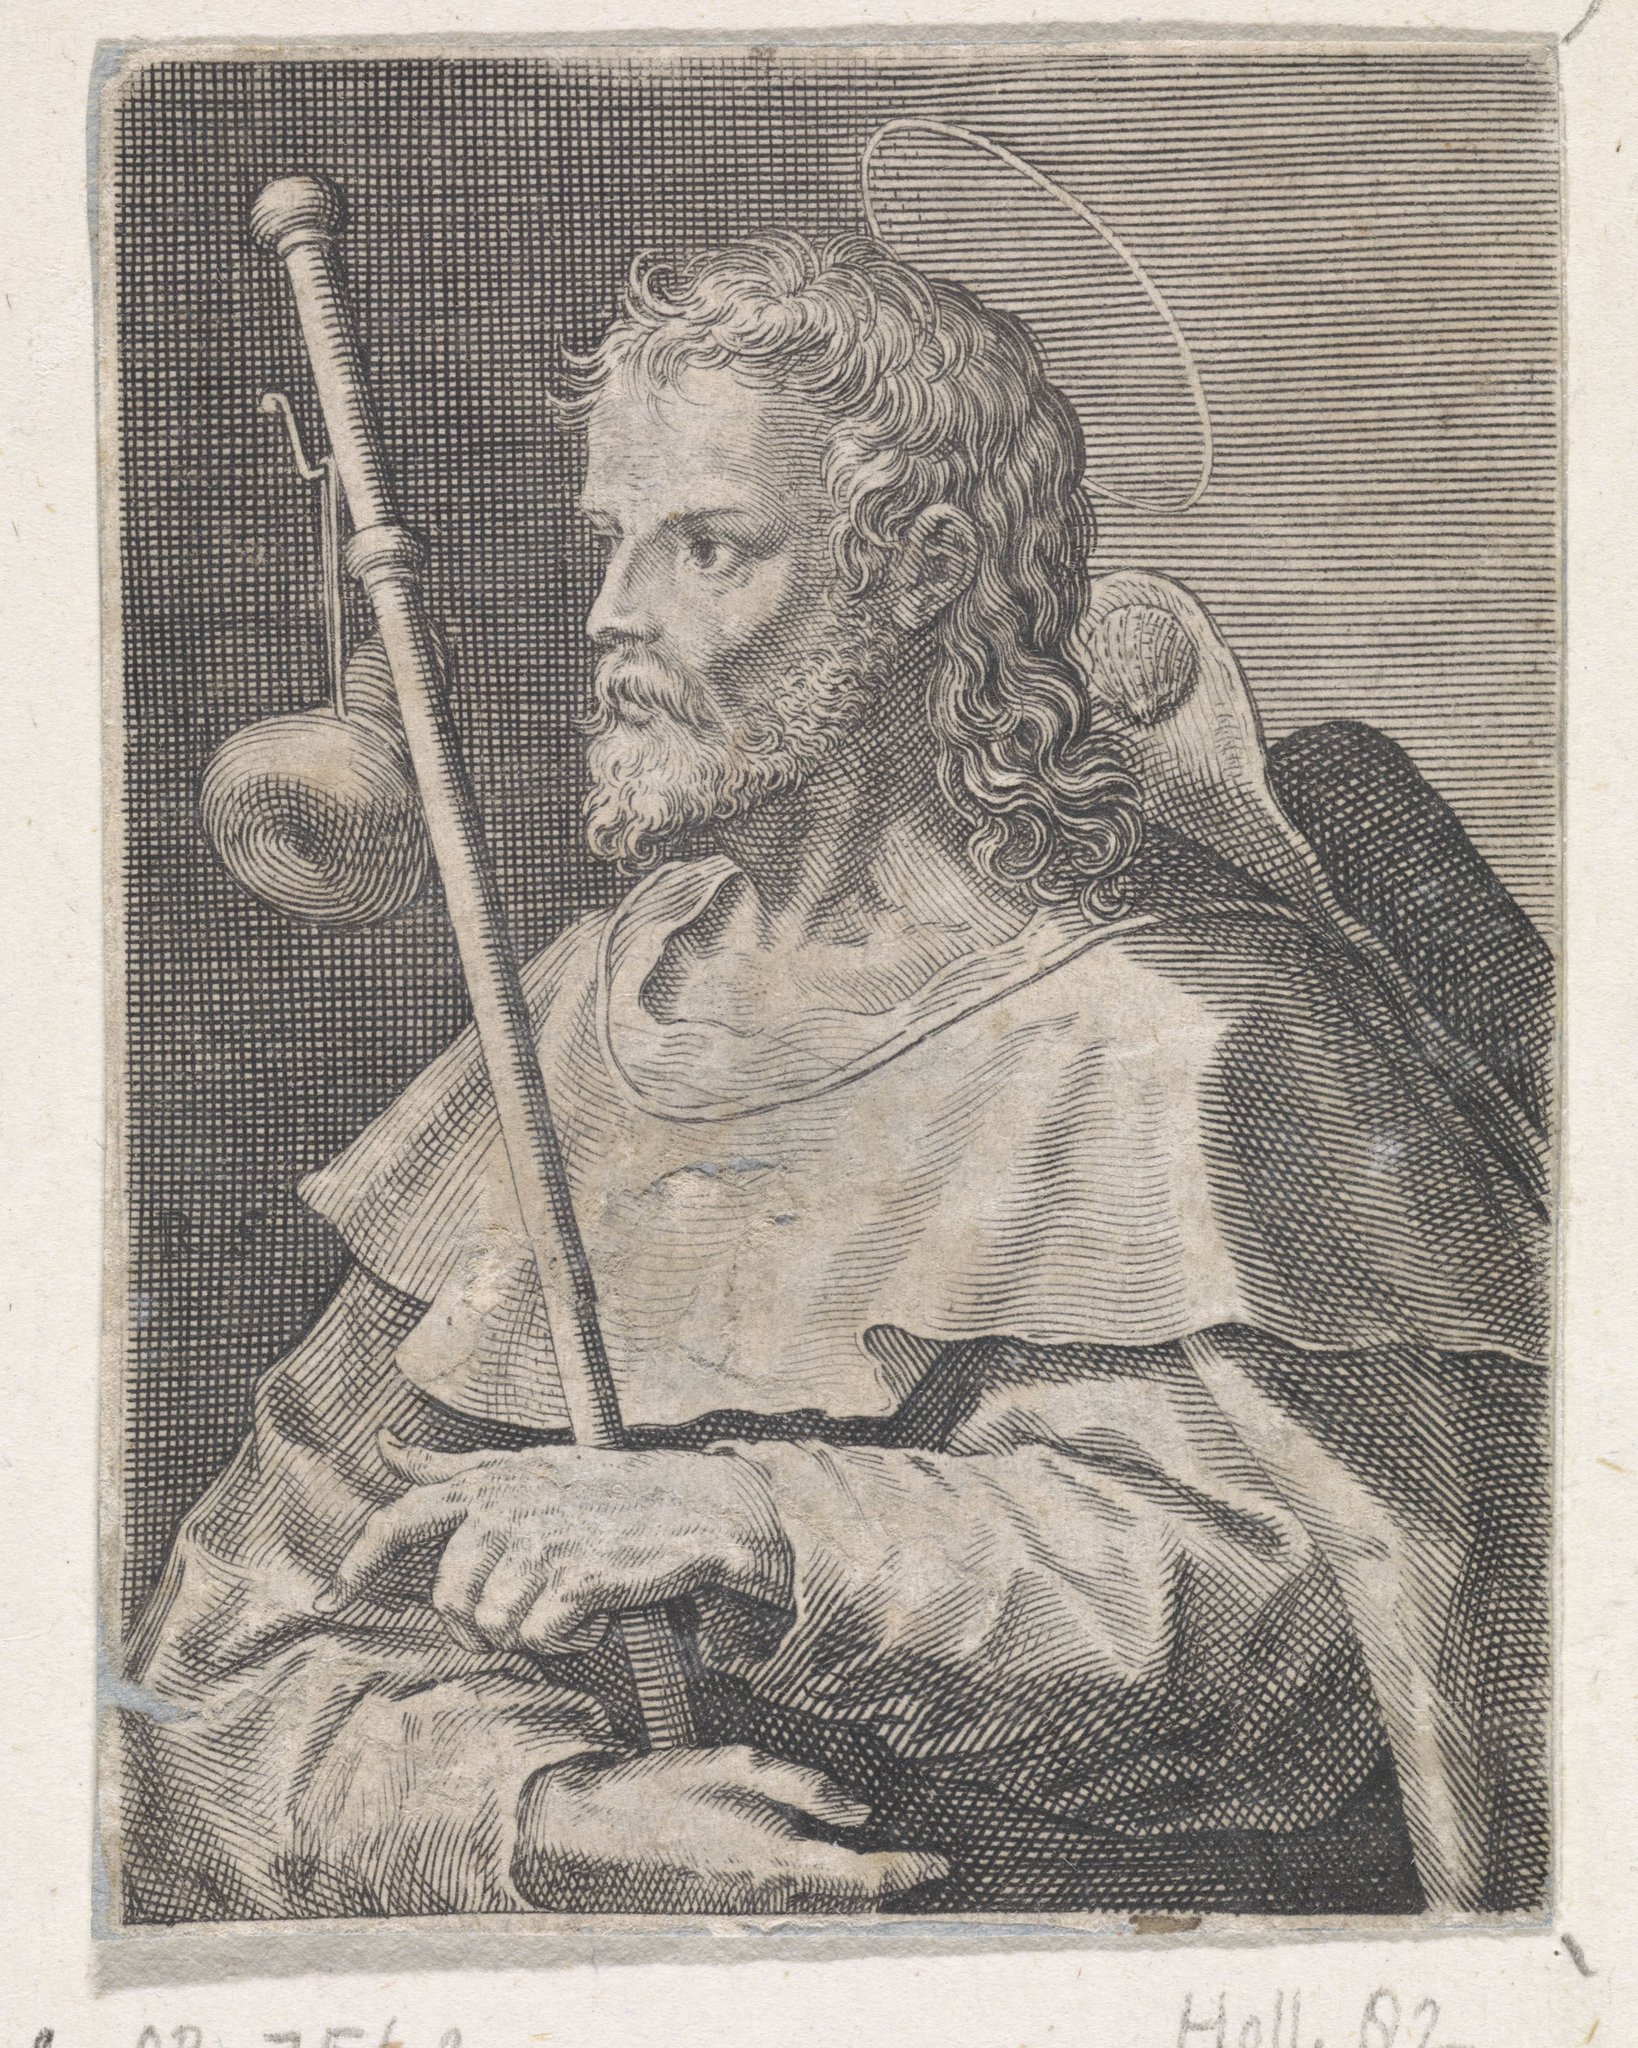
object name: print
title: Apostel Jakobus de Meerdere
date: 1570-1600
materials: paper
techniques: engraving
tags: the apostle james the great; possible attributes: book, pilgrim's cloak, hat, shell, staff, and wallet, scroll, sword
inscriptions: collector's mark: Lugt 240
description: De apostel Jakobus de Meerdere, met als attribuut de pelgrimsstaf. De prent heeft een Latijns onderschrijft met een regel uit het Credo. De vijfde prent in een serie van veertien waarvan de prenten met een apostel genummerd zijn van 1 tot 12.